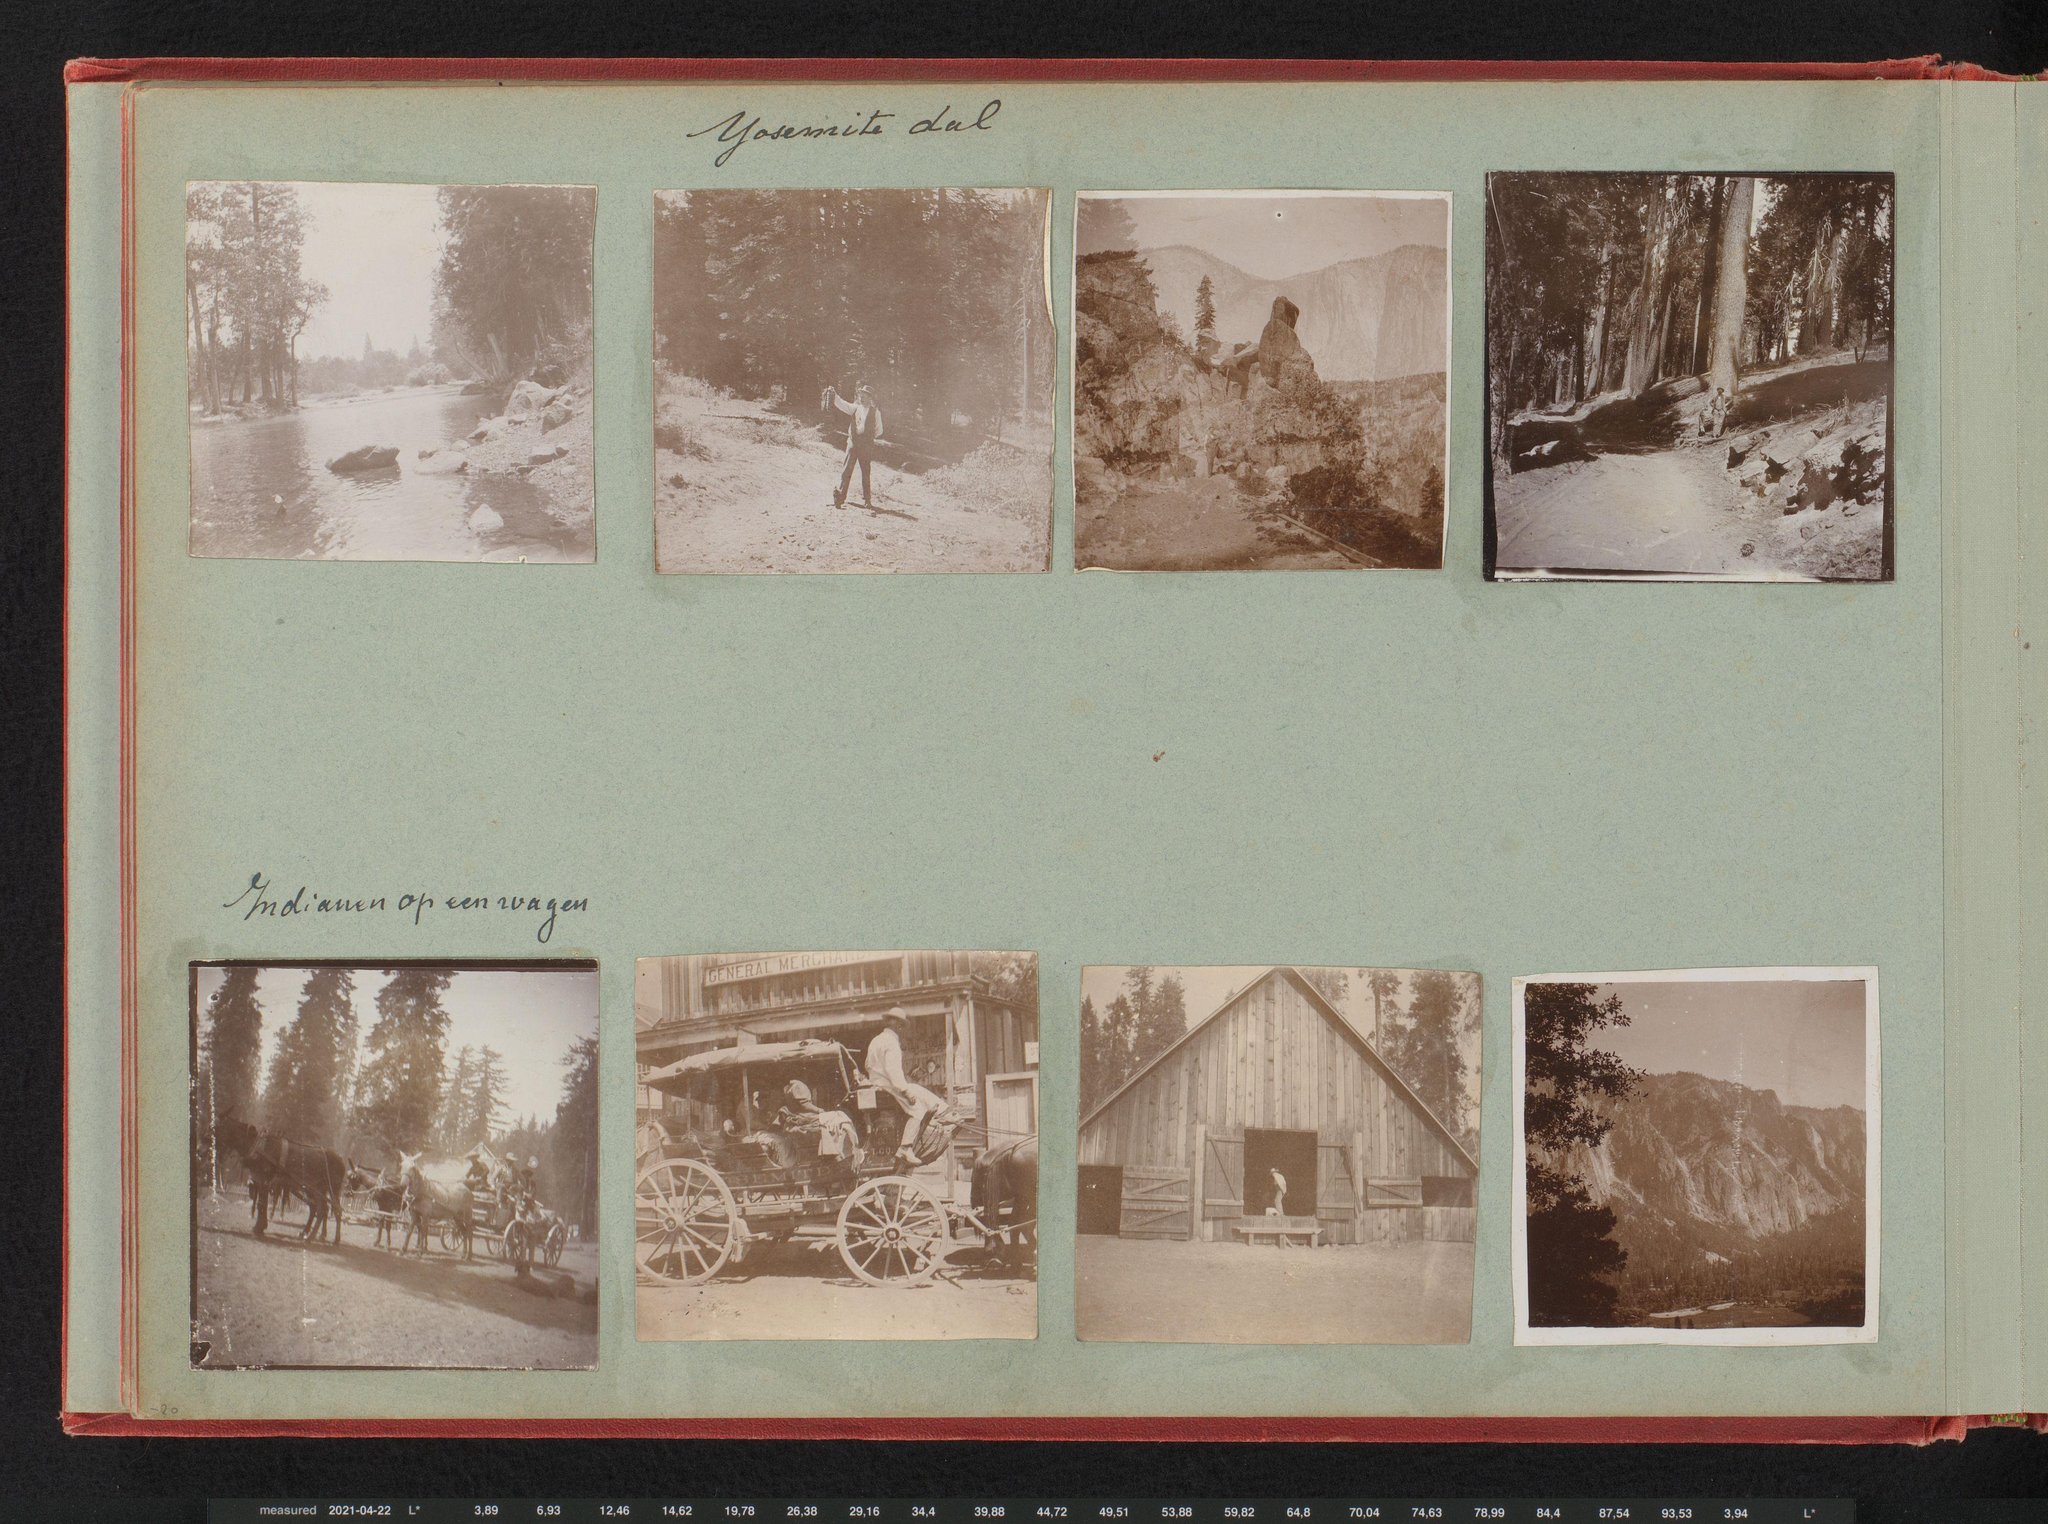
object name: photograph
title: Yosemite dal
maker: Anonymous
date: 1898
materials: paper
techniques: collodion silver print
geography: yosemite valley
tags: forest, wood, 'en route', traveller under way, mountains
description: Deze foto's zijn onderdeel van een album.